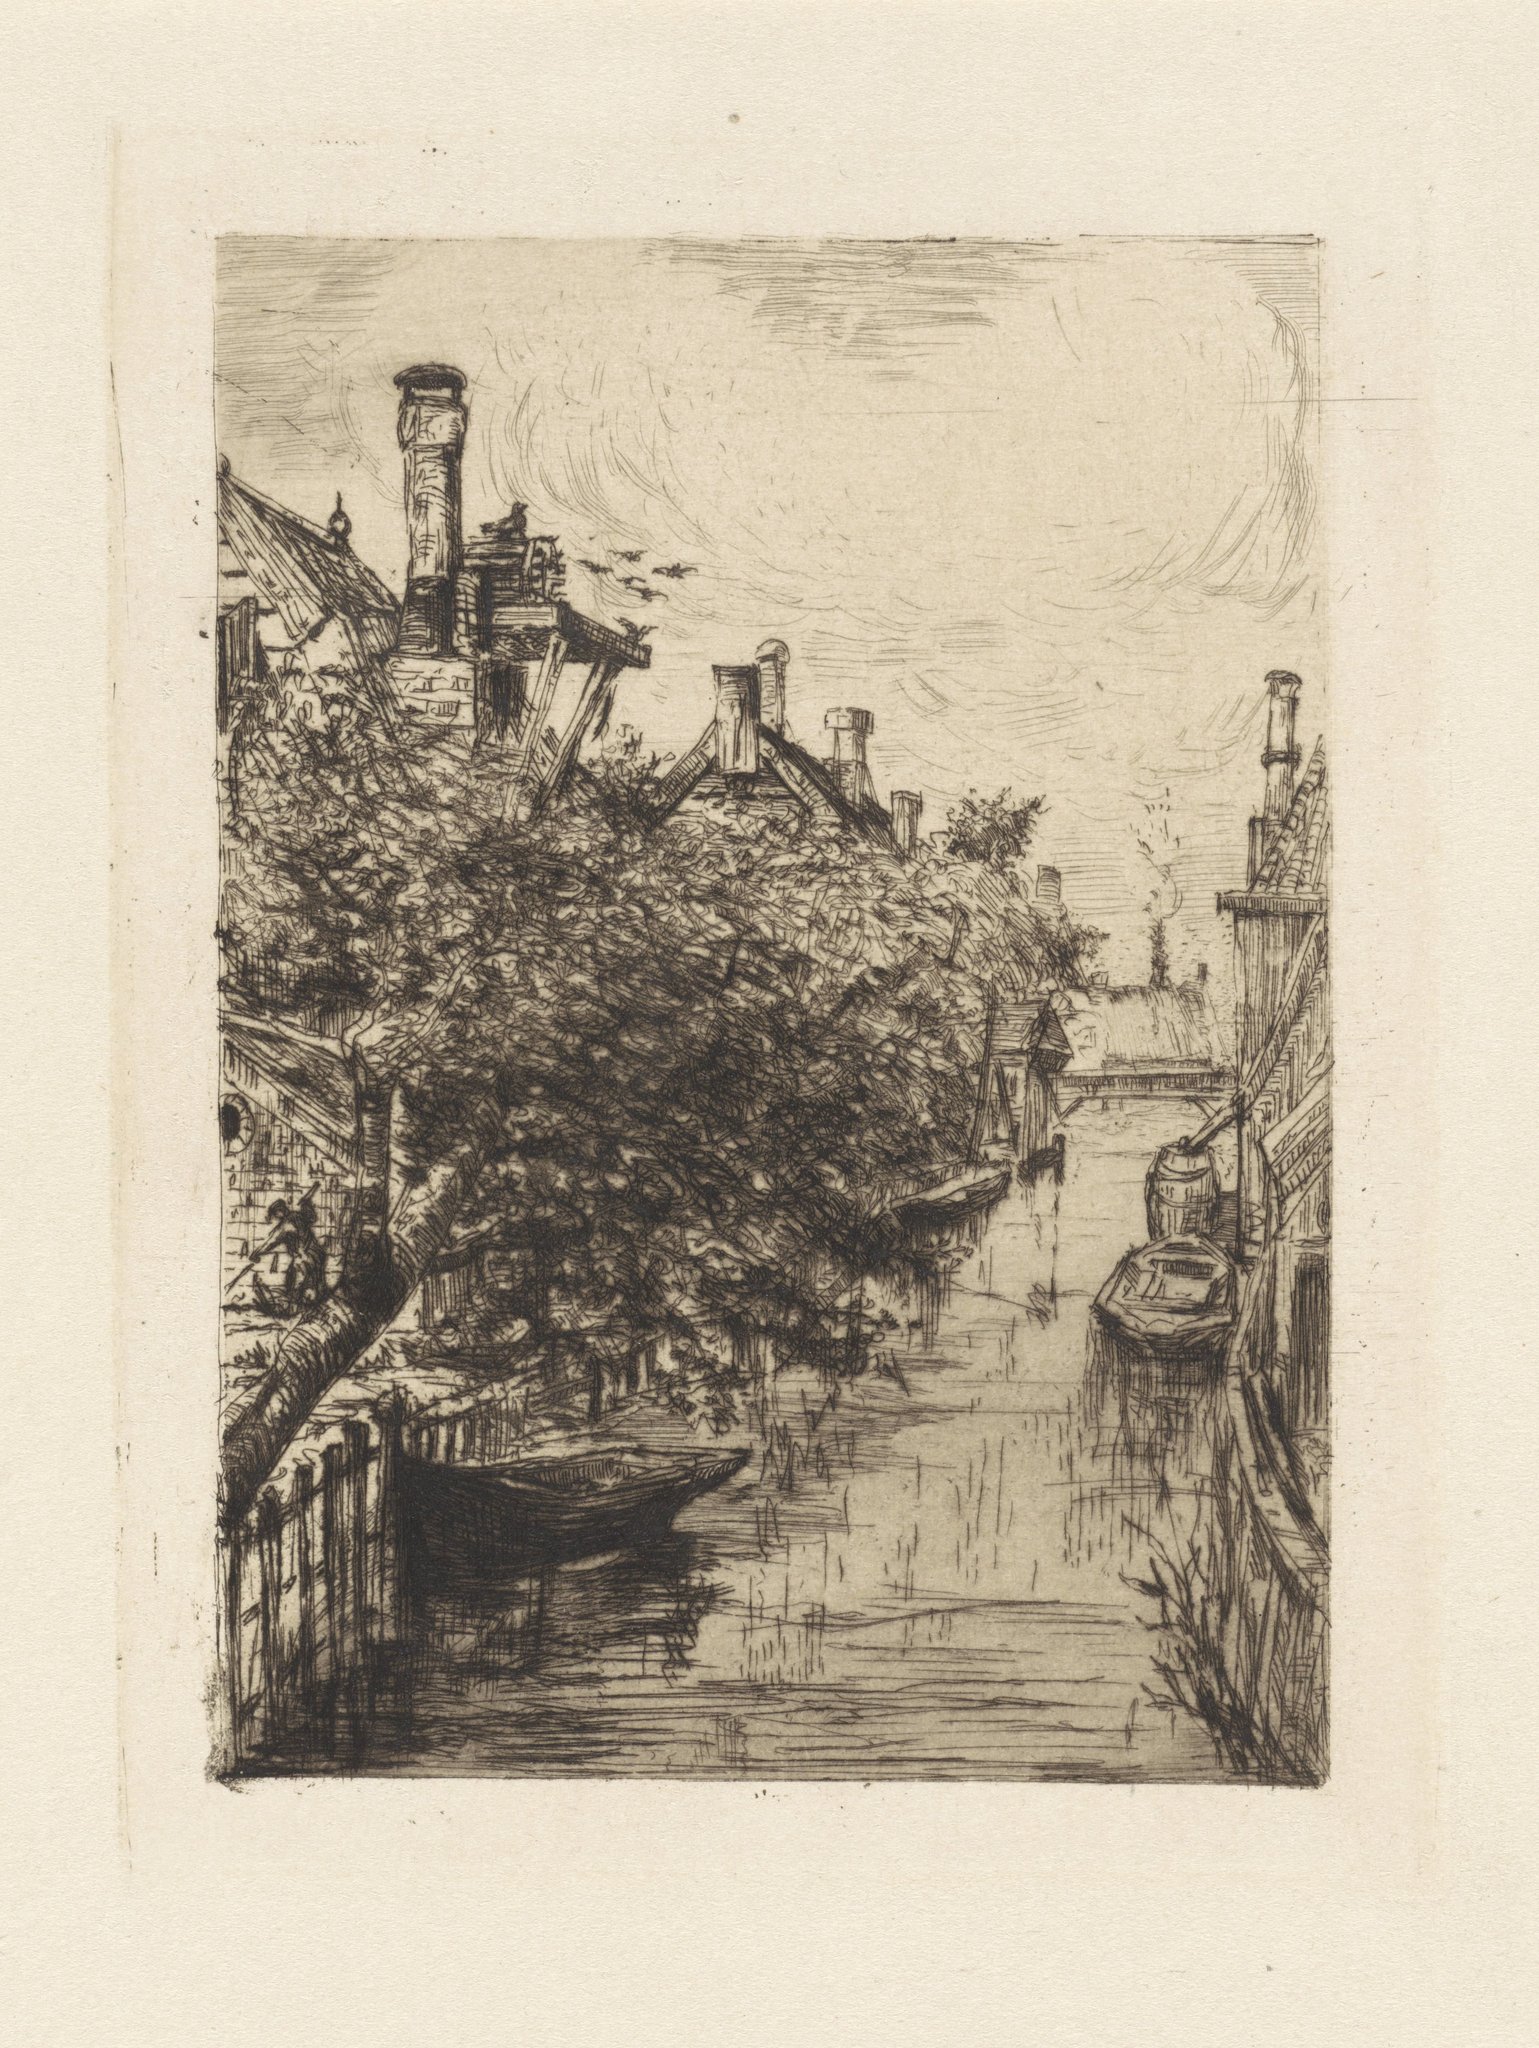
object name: print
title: Gezicht op een grachtje in Amsterdam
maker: frans schikkinger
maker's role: print maker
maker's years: 1838-1902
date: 1848-1902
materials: paper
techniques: drypoint, etching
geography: amsterdam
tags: canals, waters (in city), amsterdam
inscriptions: collector's mark: Lugt 2228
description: Gezicht op een grachtje in Amsterdam. Op de voorgrond een overhangende boom.